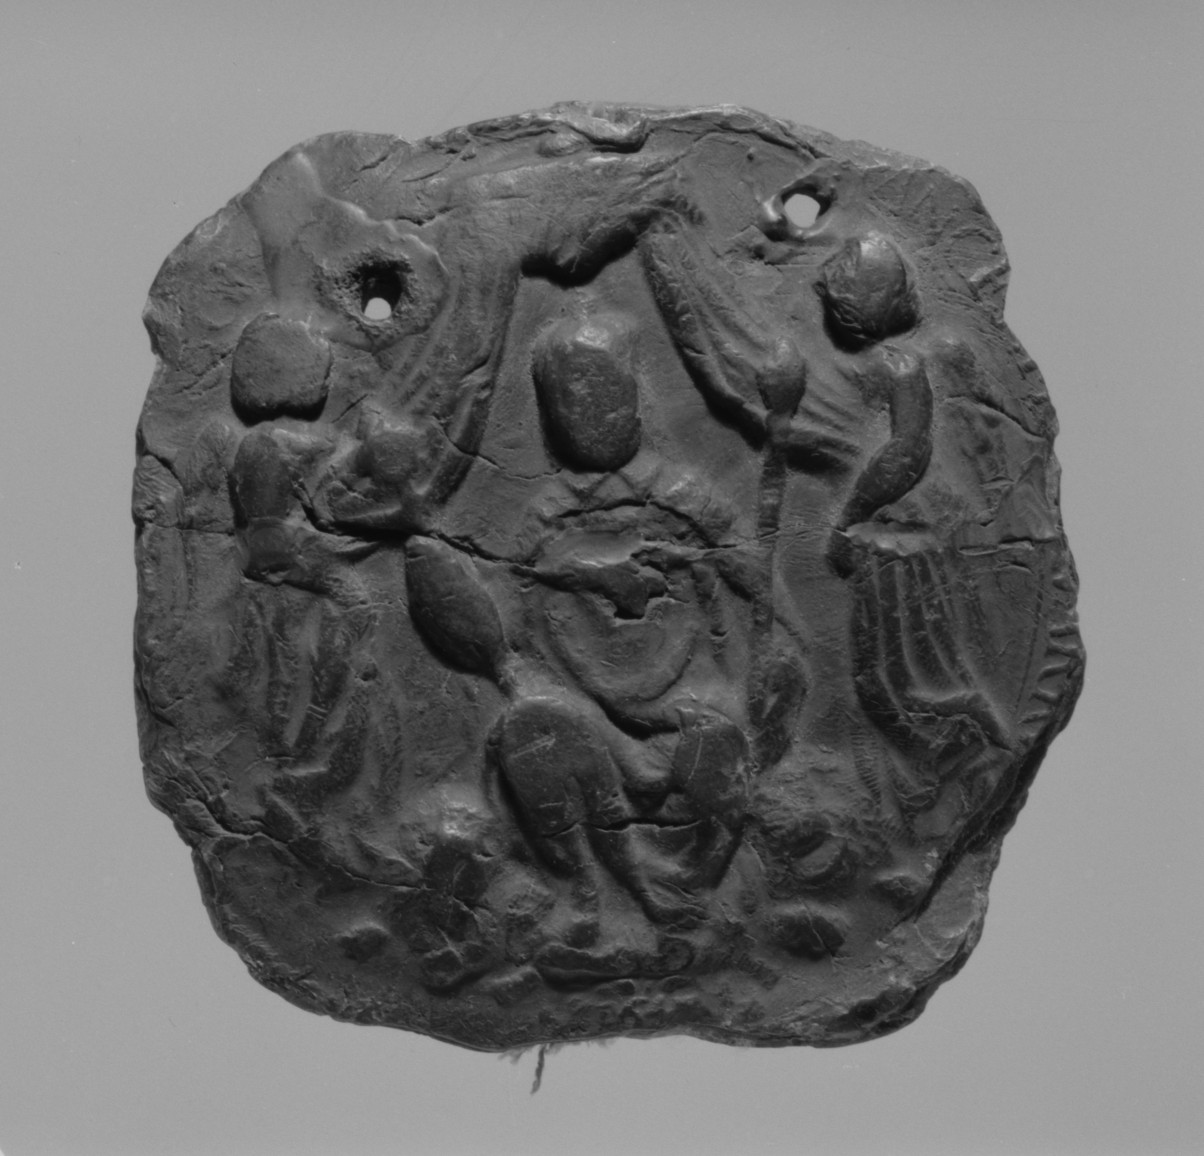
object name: wax impression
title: Seal of Louis XIV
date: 1661-1715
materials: wax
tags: louis xiv